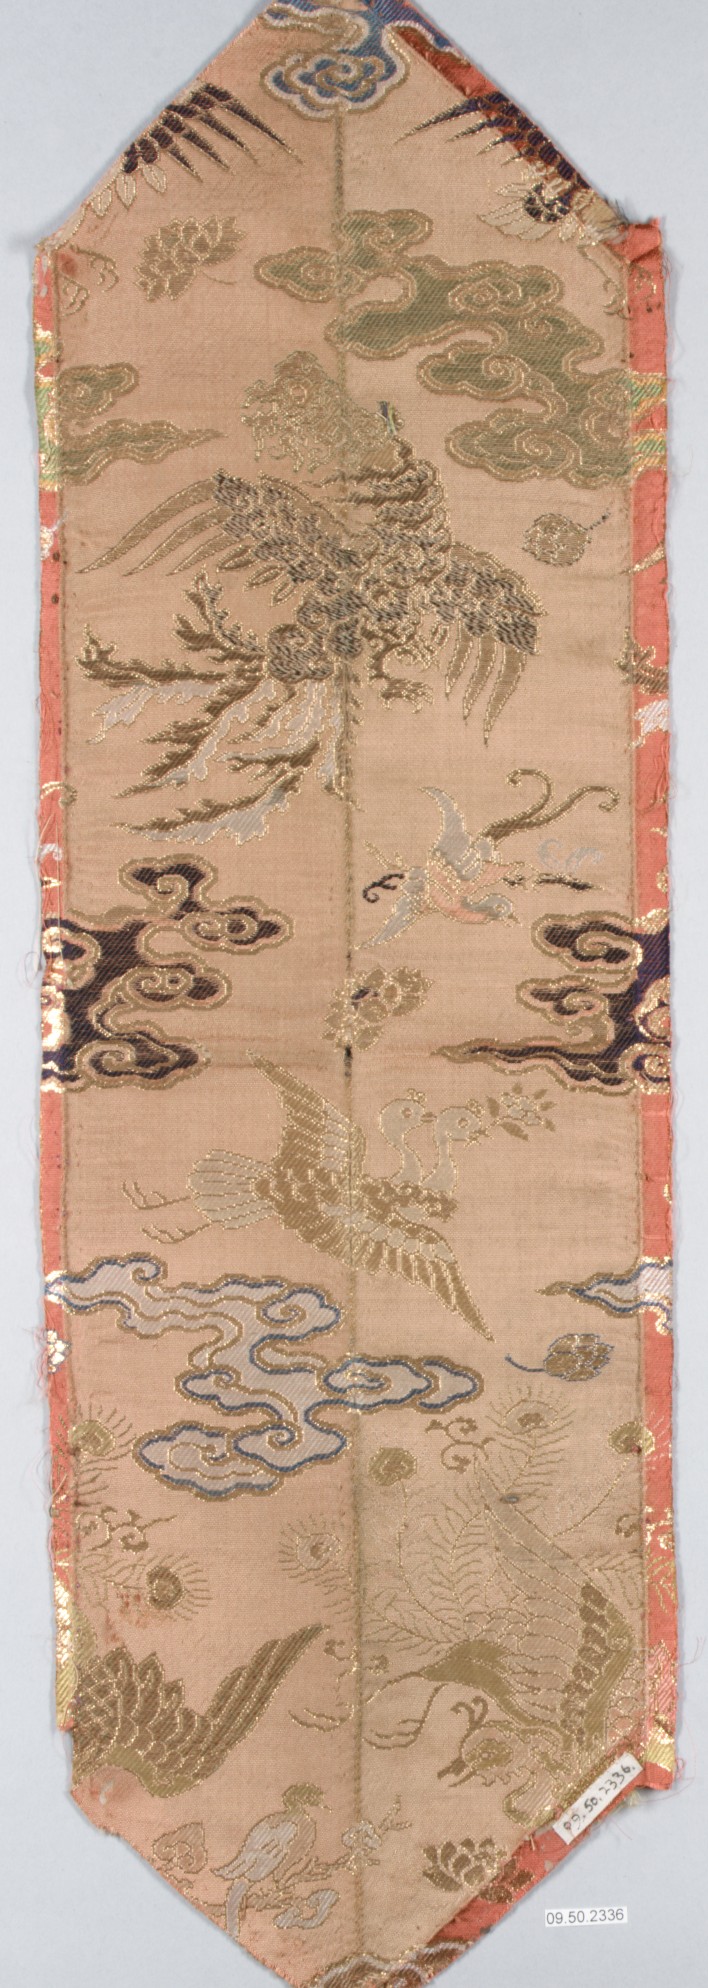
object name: piece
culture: japanese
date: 1701-1800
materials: silk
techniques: brocade